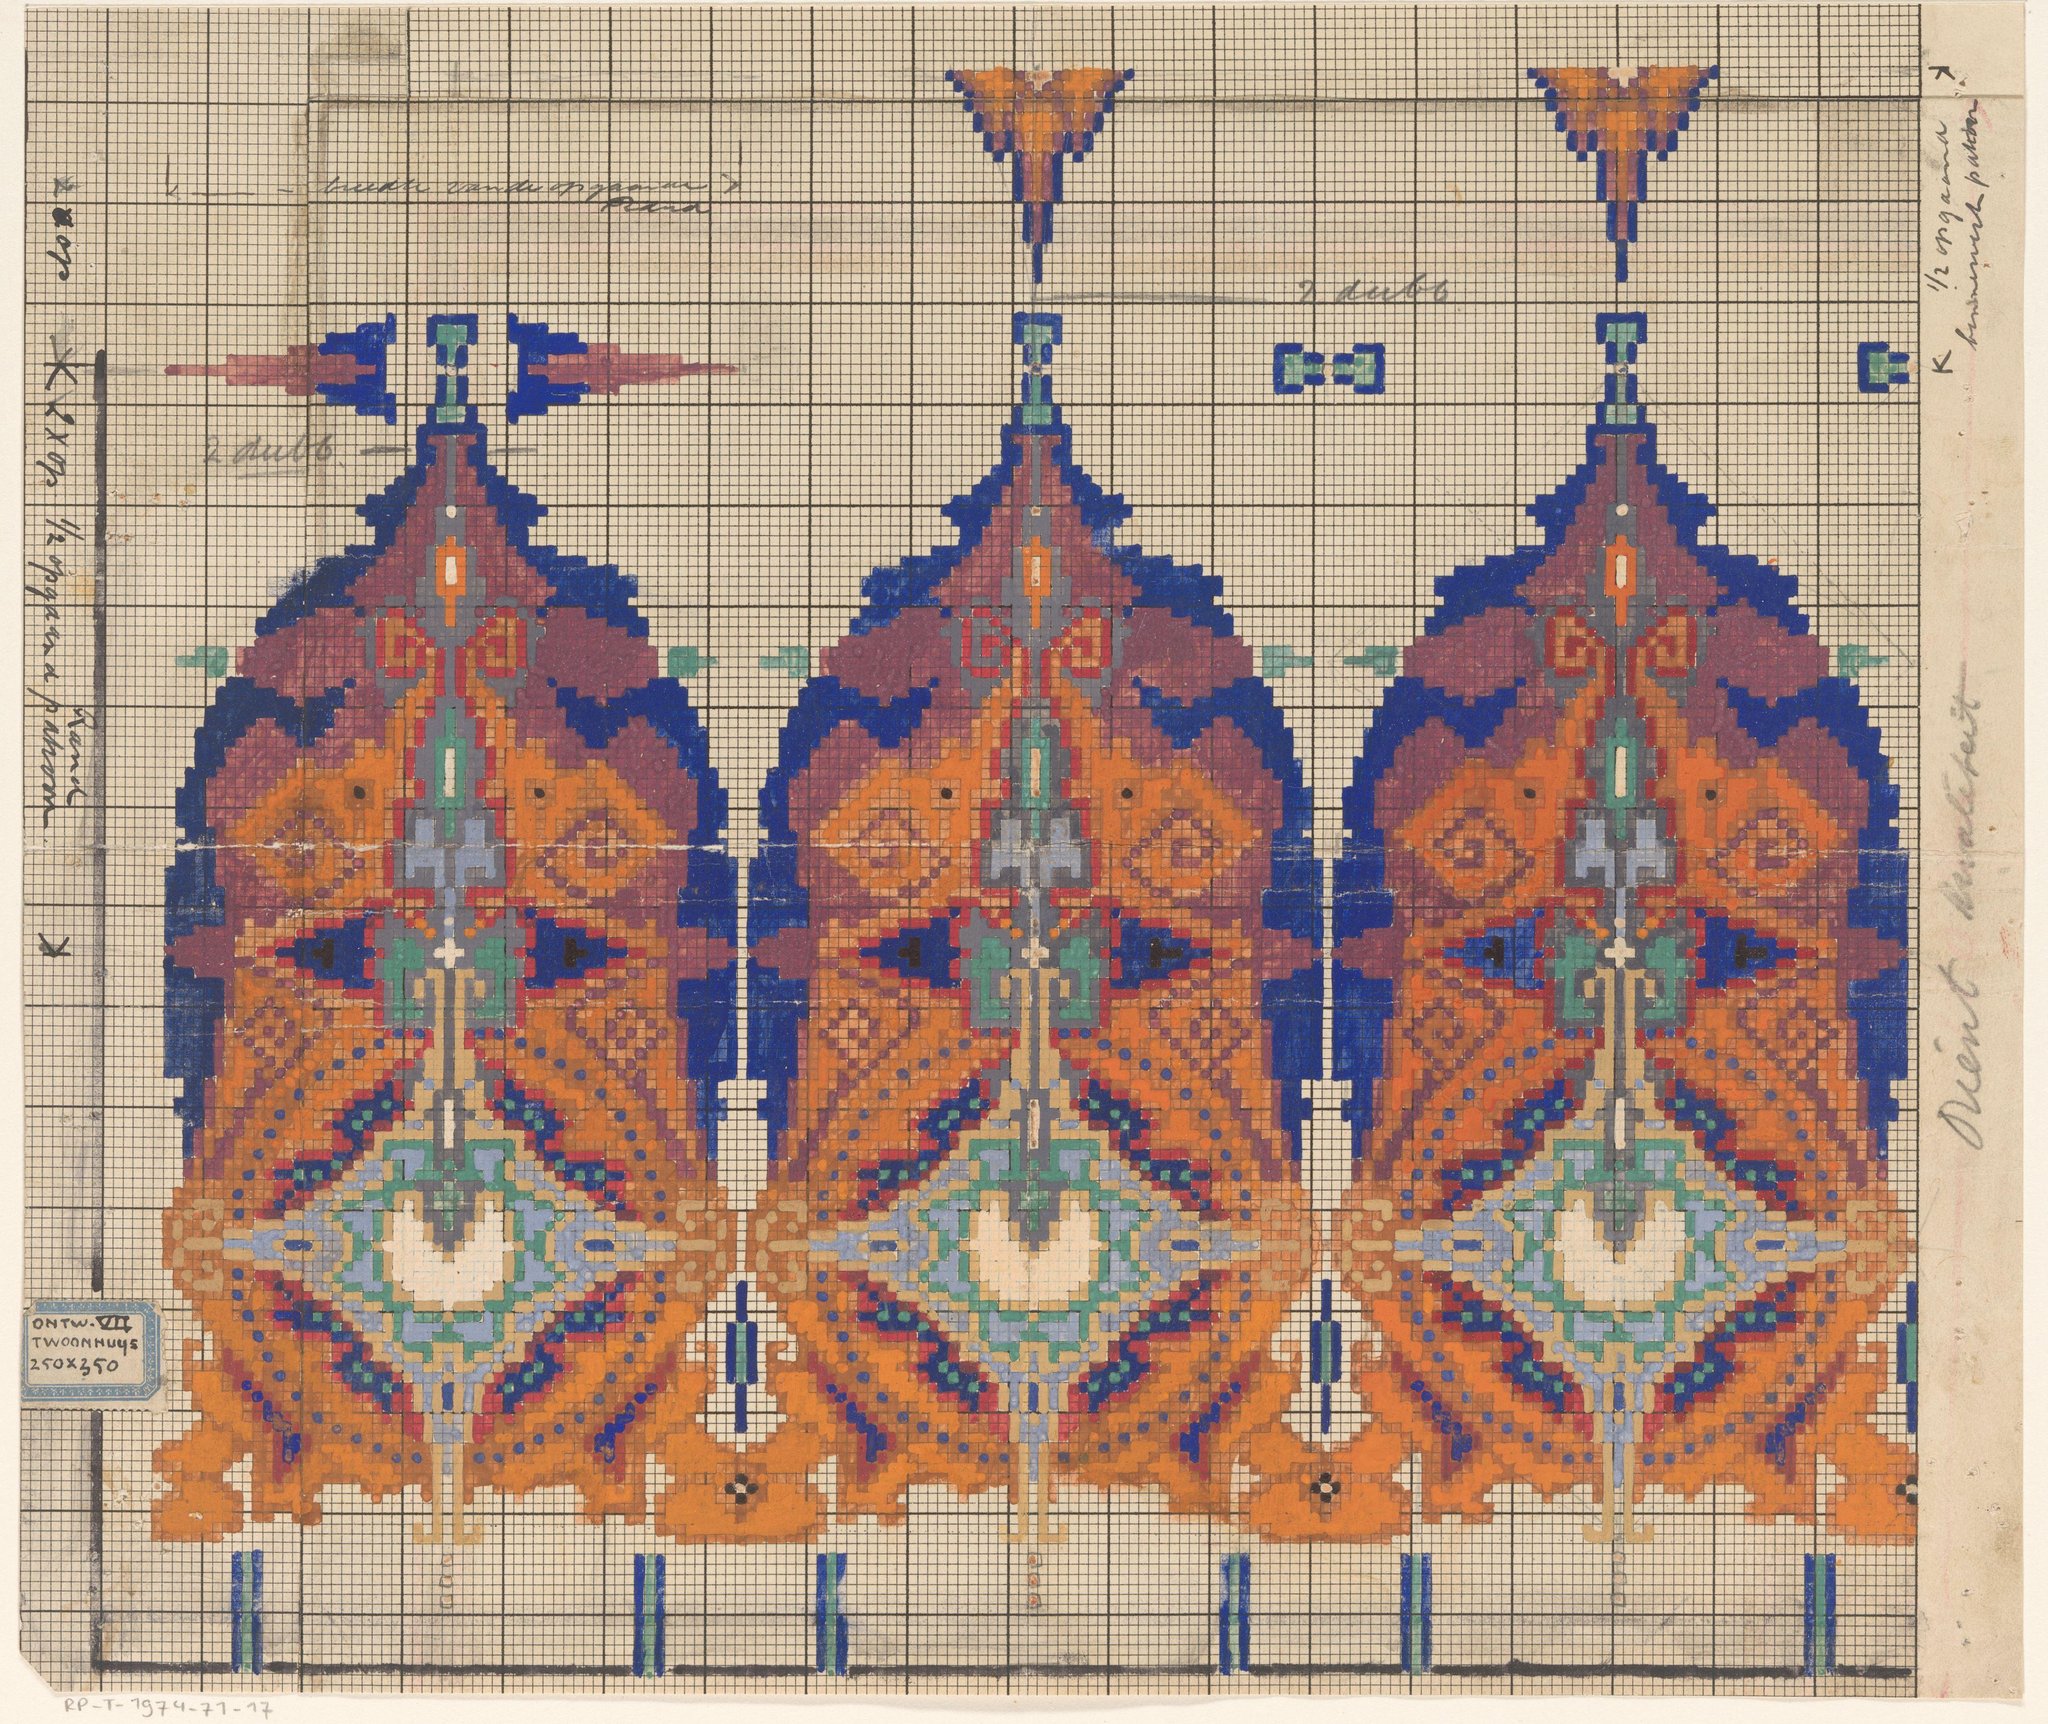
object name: drawing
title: Ontwerp voor een tapijt met Oosters patroon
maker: dirk verstraten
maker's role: designer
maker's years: 1892-1946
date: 1920-1930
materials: paint, paper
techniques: brush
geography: amsterdam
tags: ornaments ~ art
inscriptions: collector's mark: ‘R:MVS’, inscription: ‘ONTW VII/ T WOONHUYS/ 250 x 350’, annotation, annotation: ‘Orient kwaliteit’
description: Bij het ontwerp wordt een handgeschreven beschrijving van de order en het patroon bewaard, evenals een stuk papier met daarop 'VII.W'.